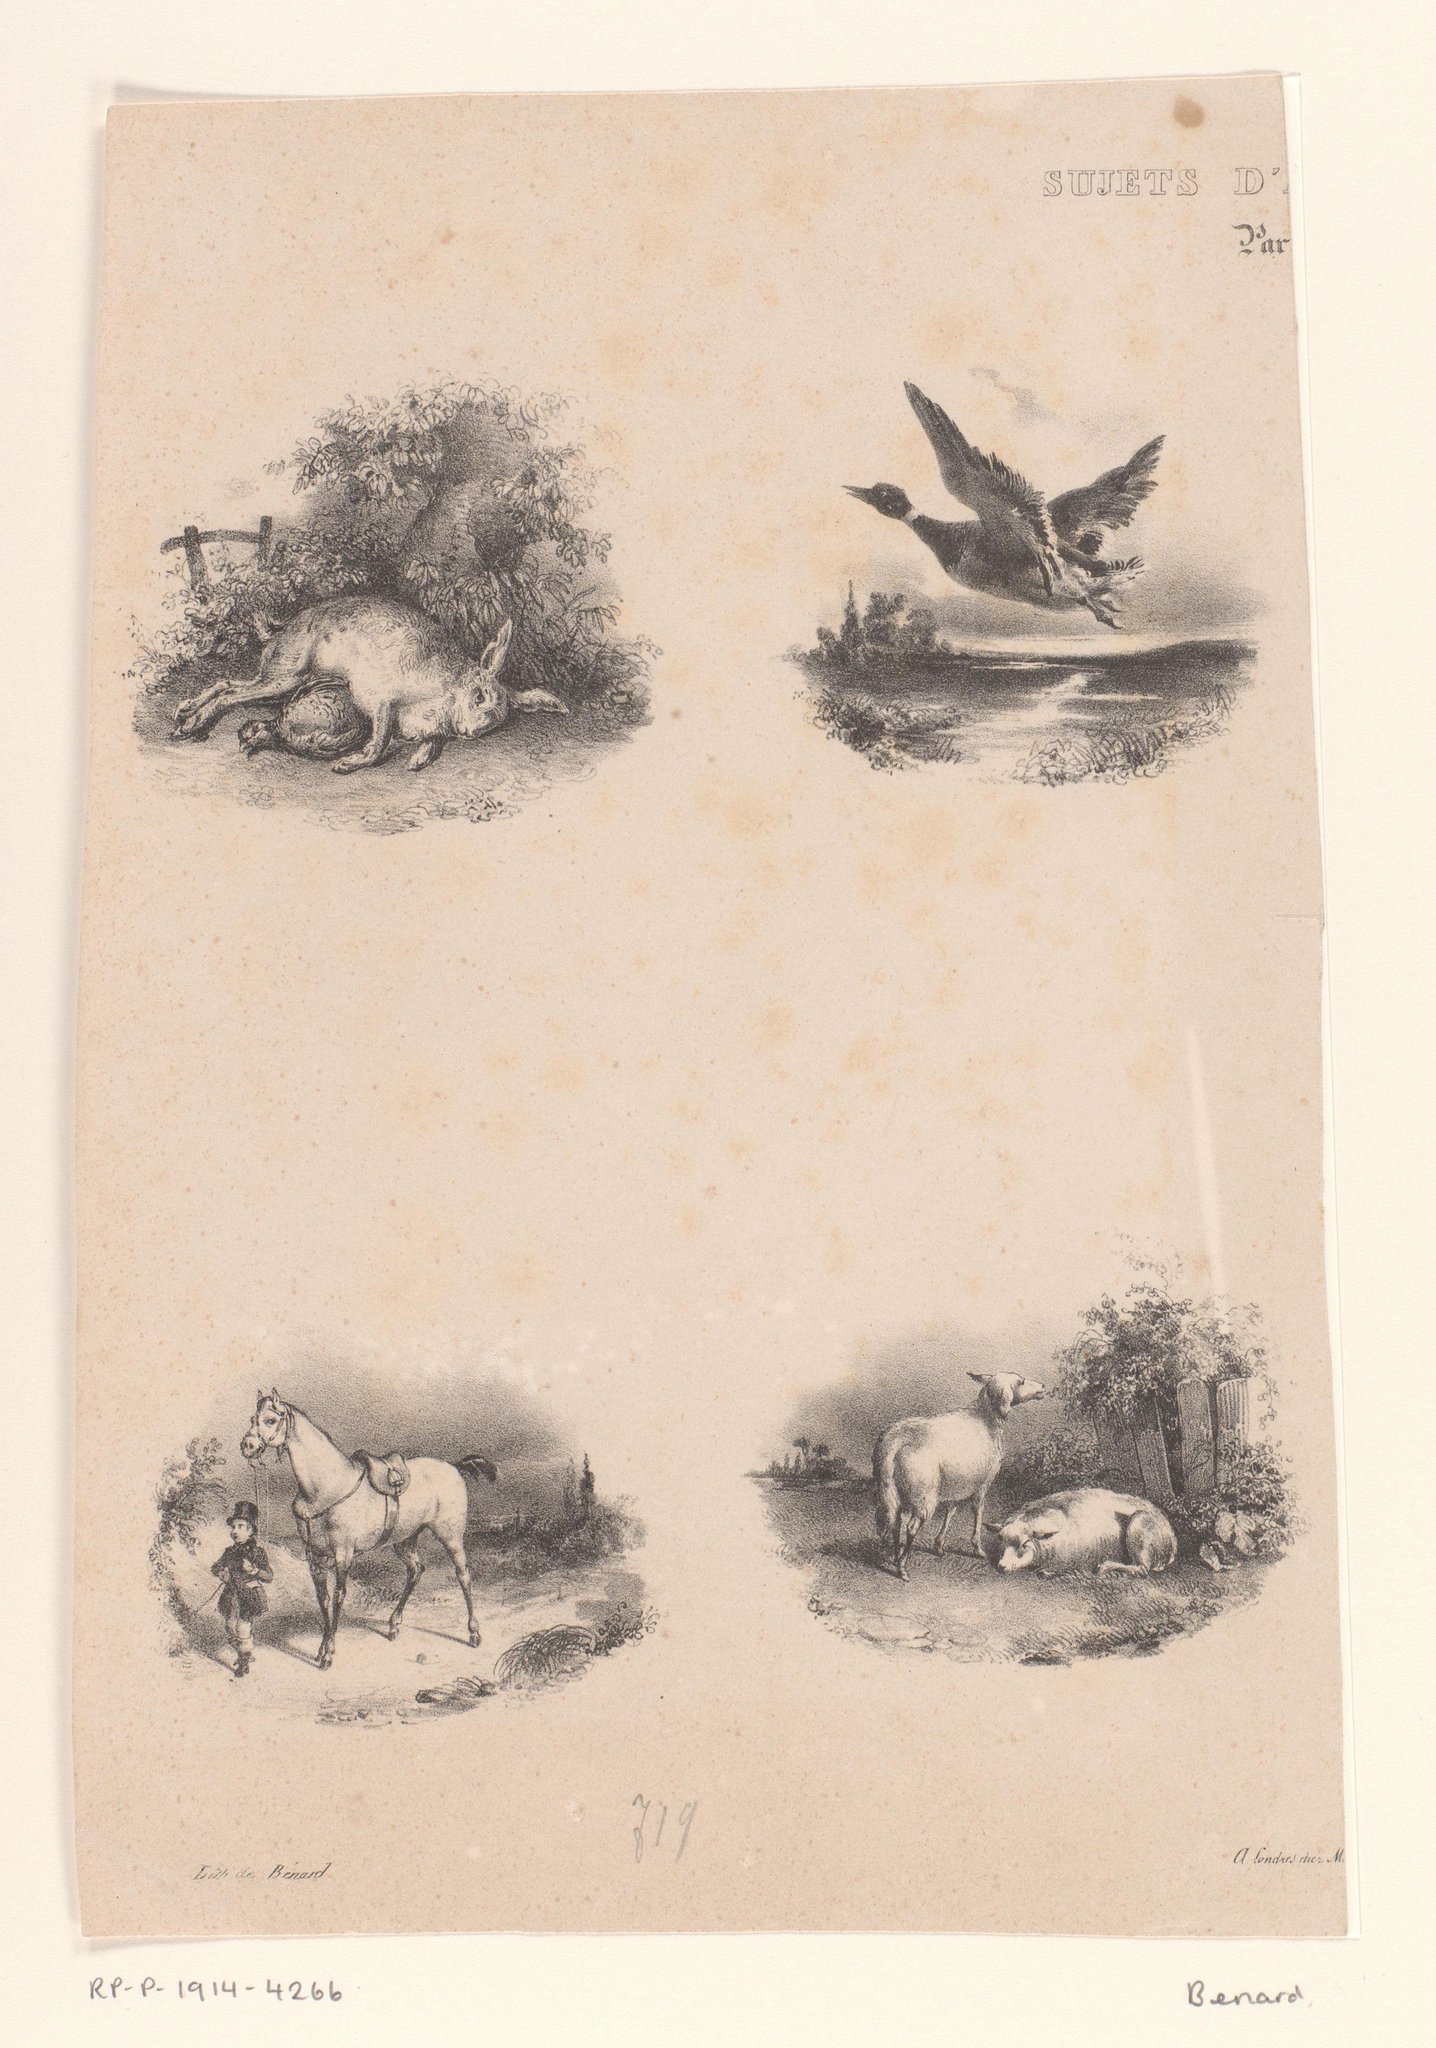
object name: print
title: Dieren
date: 1832-1850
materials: paper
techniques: lithograph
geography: paris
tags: animals, hare-hunting, rabbit-hunting, sheep, horse, water-birds: duck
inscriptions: number: ‘719’, collector's mark: Lugt 2228a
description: Vier voorstellingen van dieren, waaronder een geschoten haas en fazant, een vliegende eend, een paard dat door zijn ruiter aan de teugel wordt geleid en twee schapen in een weiland.